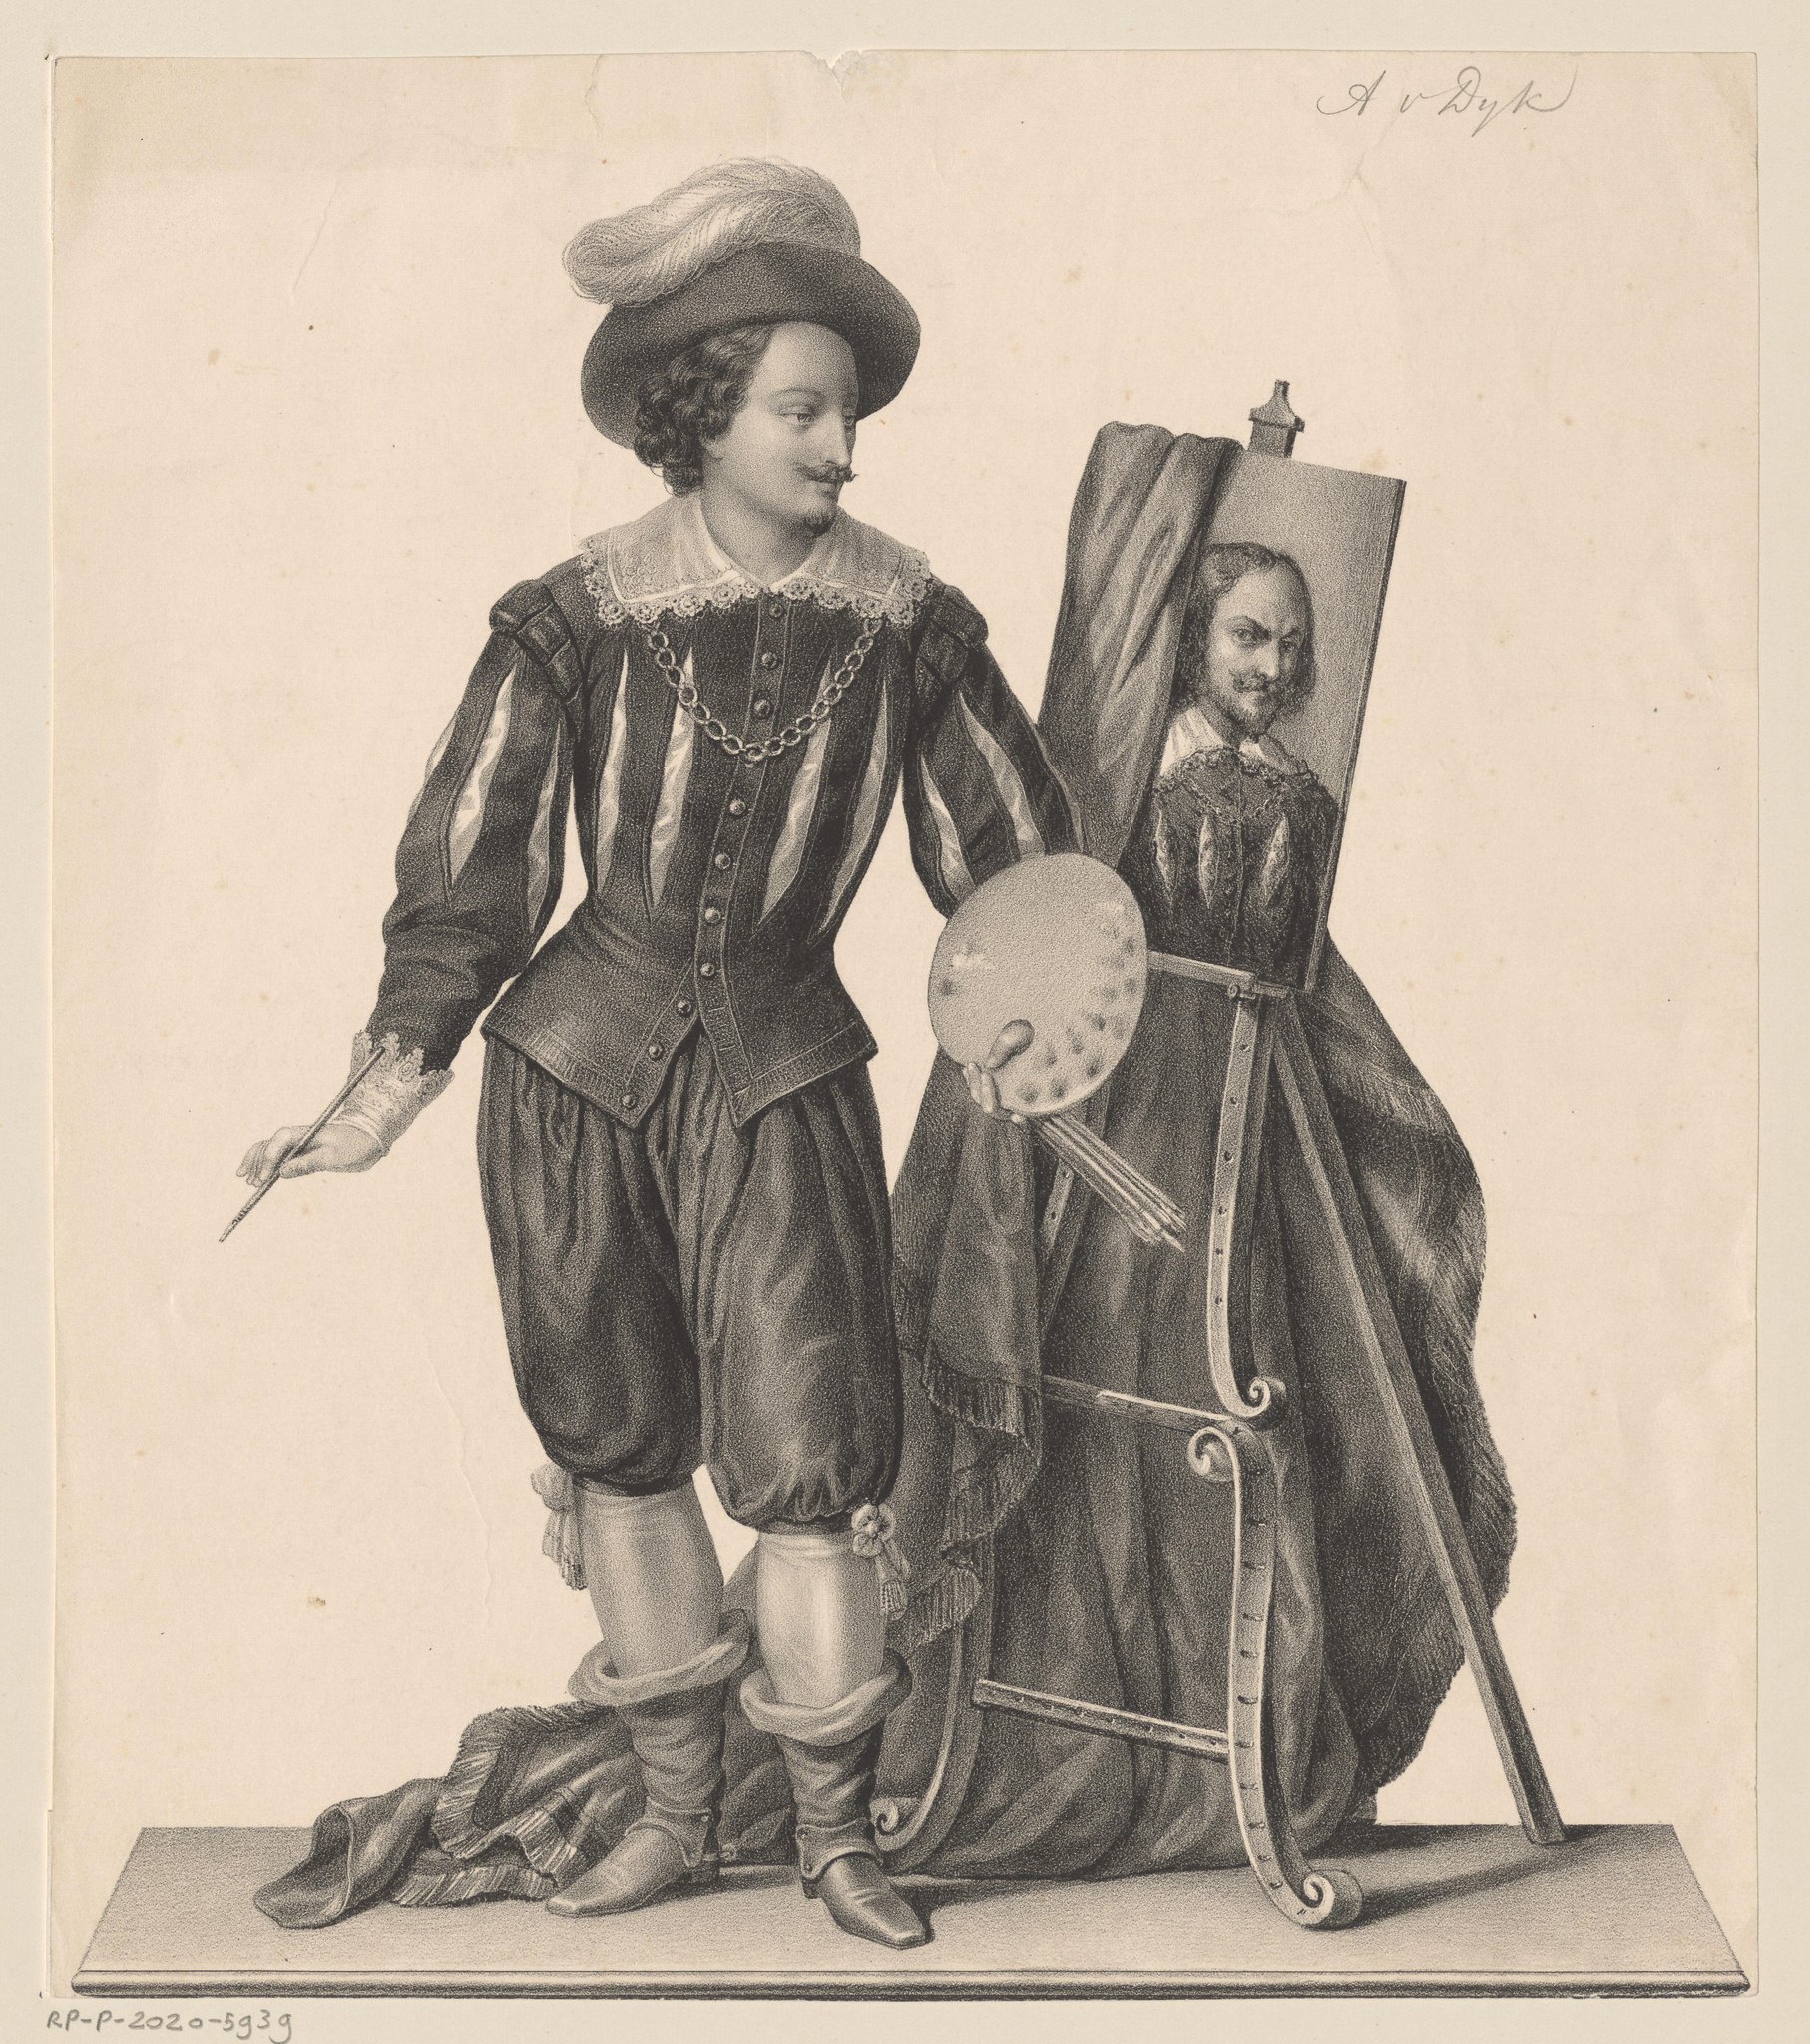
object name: print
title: Portret van Anthony van Dyck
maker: Anonymous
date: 1800-1899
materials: paper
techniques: lithograph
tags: antwerp, london, painter, print maker, draughtsman, anthony van dyck, historical persons, portrait, self-portrait of painter, tools, implements of painter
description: Staand naast een schildersezel en met een palet en penselen in zijn handen.